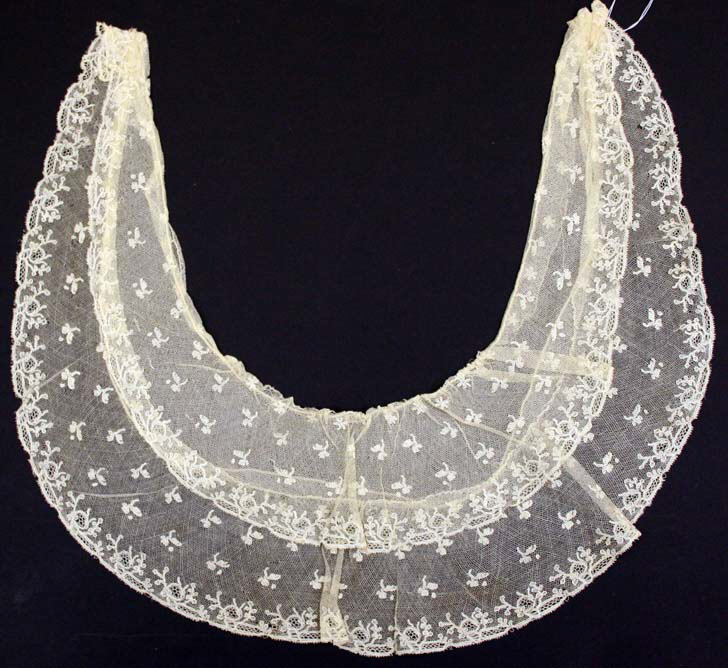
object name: collar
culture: american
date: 1801-1900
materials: cotton